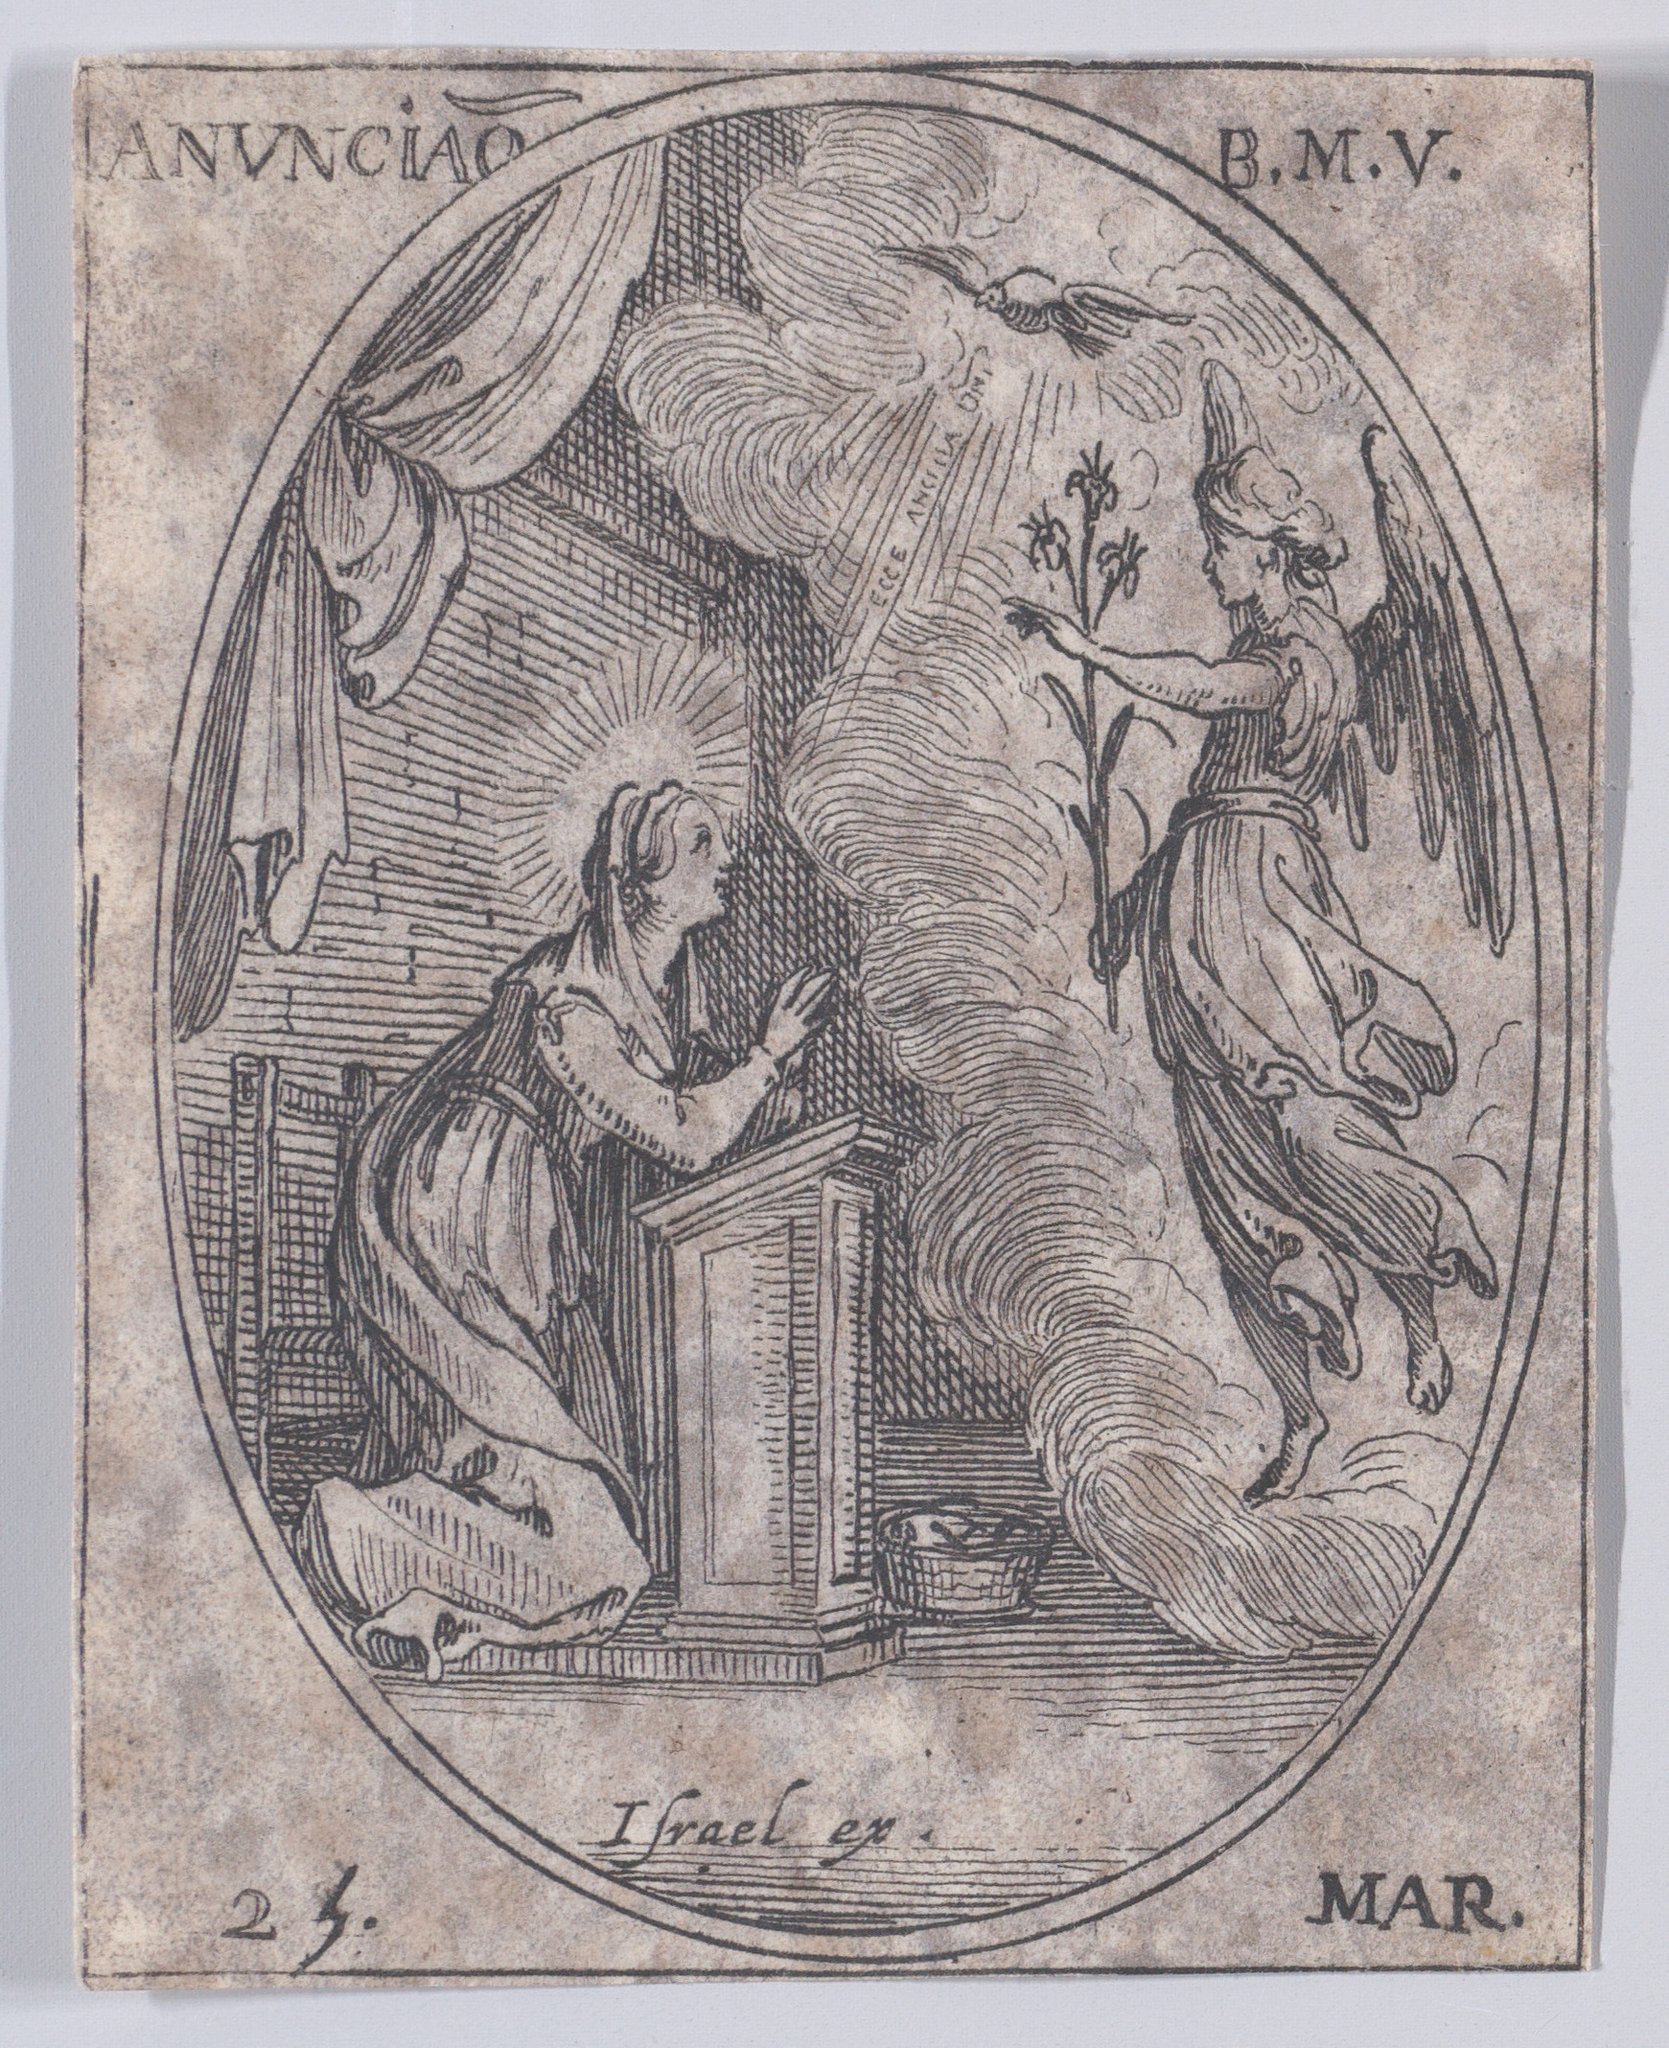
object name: print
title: L'Annonciation de la Ste. Vierge (The Annunciation of the Virgin), March 25th, from "Les Images De Tous Les Saincts et Saintes de L'Année" (Images of All of the Saints and Religious Events of the Year)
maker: jacques callot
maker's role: artist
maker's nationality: french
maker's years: 1592-1635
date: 1636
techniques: etching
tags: virgin mary,archangel gabriel,annunciation